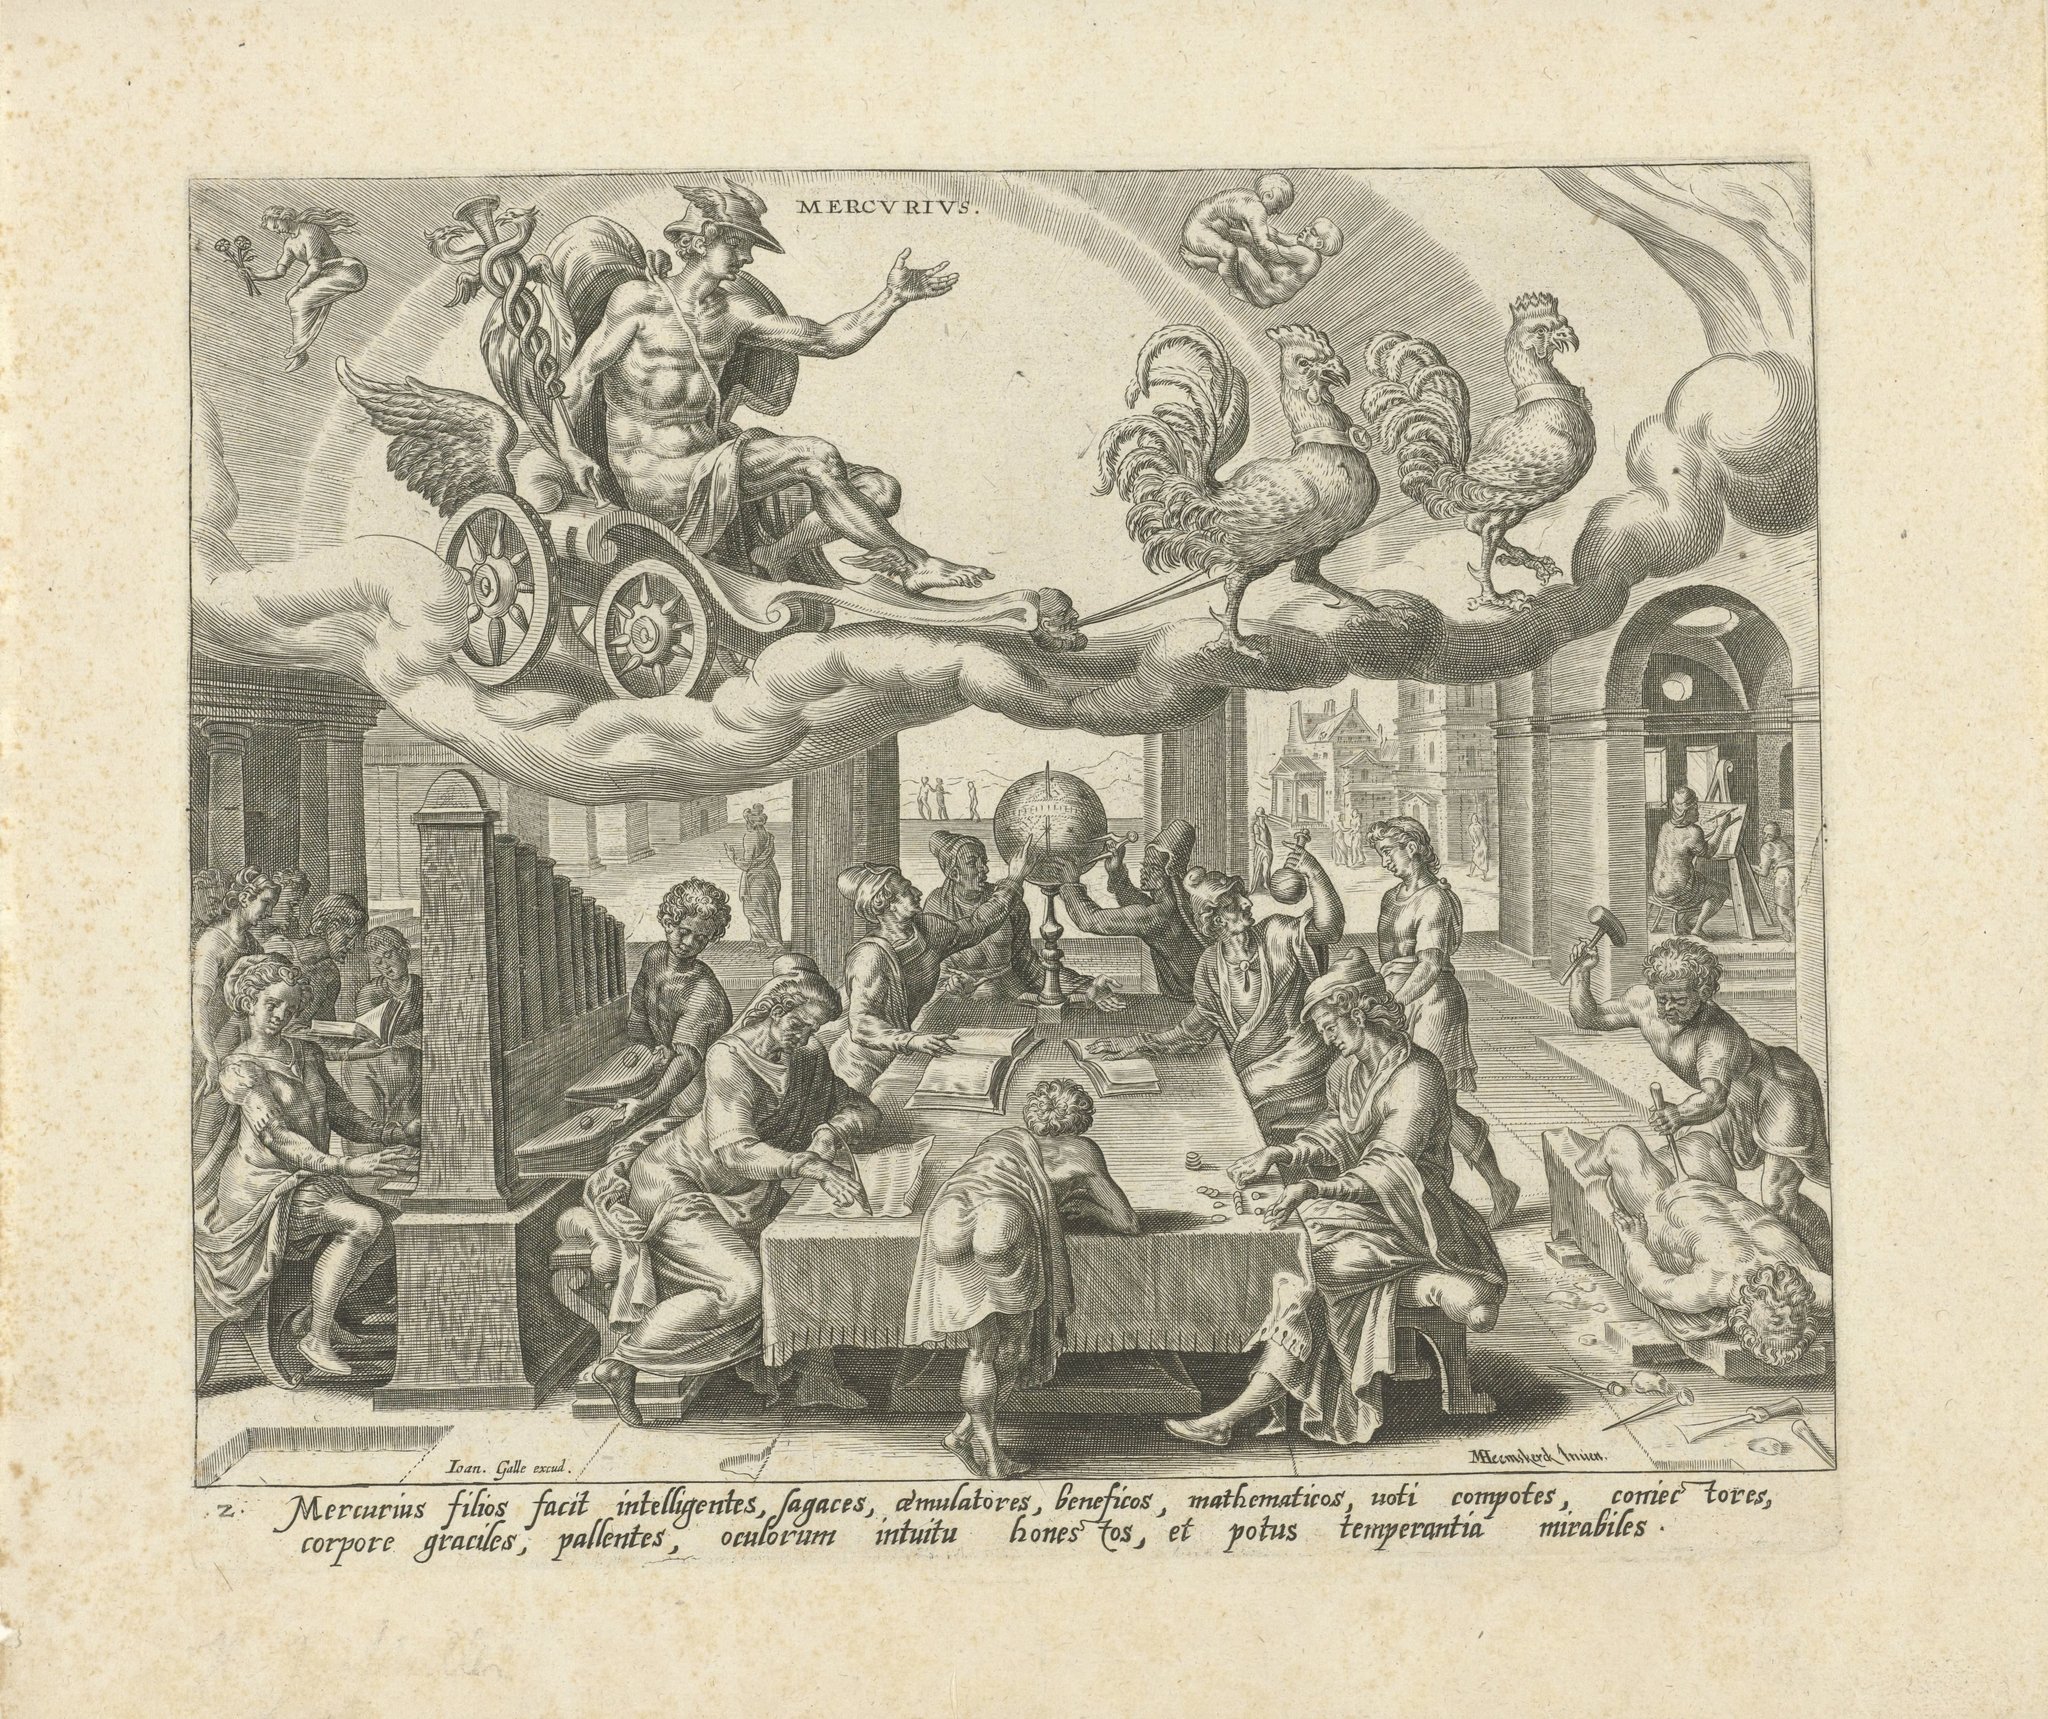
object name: print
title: De zeven planeten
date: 1566-1570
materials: paper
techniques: engraving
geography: antwerp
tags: sculptor at work, mercury and his children ('planetenkinder') ~ gemini and virgo, organ, astrologer at work, painter at work, in his studio, fowl (cock, hen, chicken, etc.)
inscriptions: collector's mark: Lugt 2228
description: Prent mogelijk gebruikt in: Speculum diversarum imaginum speculativarum a variis doctis adinventarum, atque ab insignibus pictoribus ac sculptoribus delineatarum. Antwerpen: Johannes Galle, 1638. Of in: Schabaelje, Jan Philipsz. Den grooten figver-bibel. Dat is een afbeeldingh en levendighe vertooningh, van alle de voornaemste historien (...) der gantscher Heyliger Schrift, in schoone copere figueren (...) verrijckt met leersame verclaeringhen over de selve figueren. Alkmaar: Simon Cornelisz Brekegeest, Amsterdam: Jan Philipsz. Schabaelje, 1646.